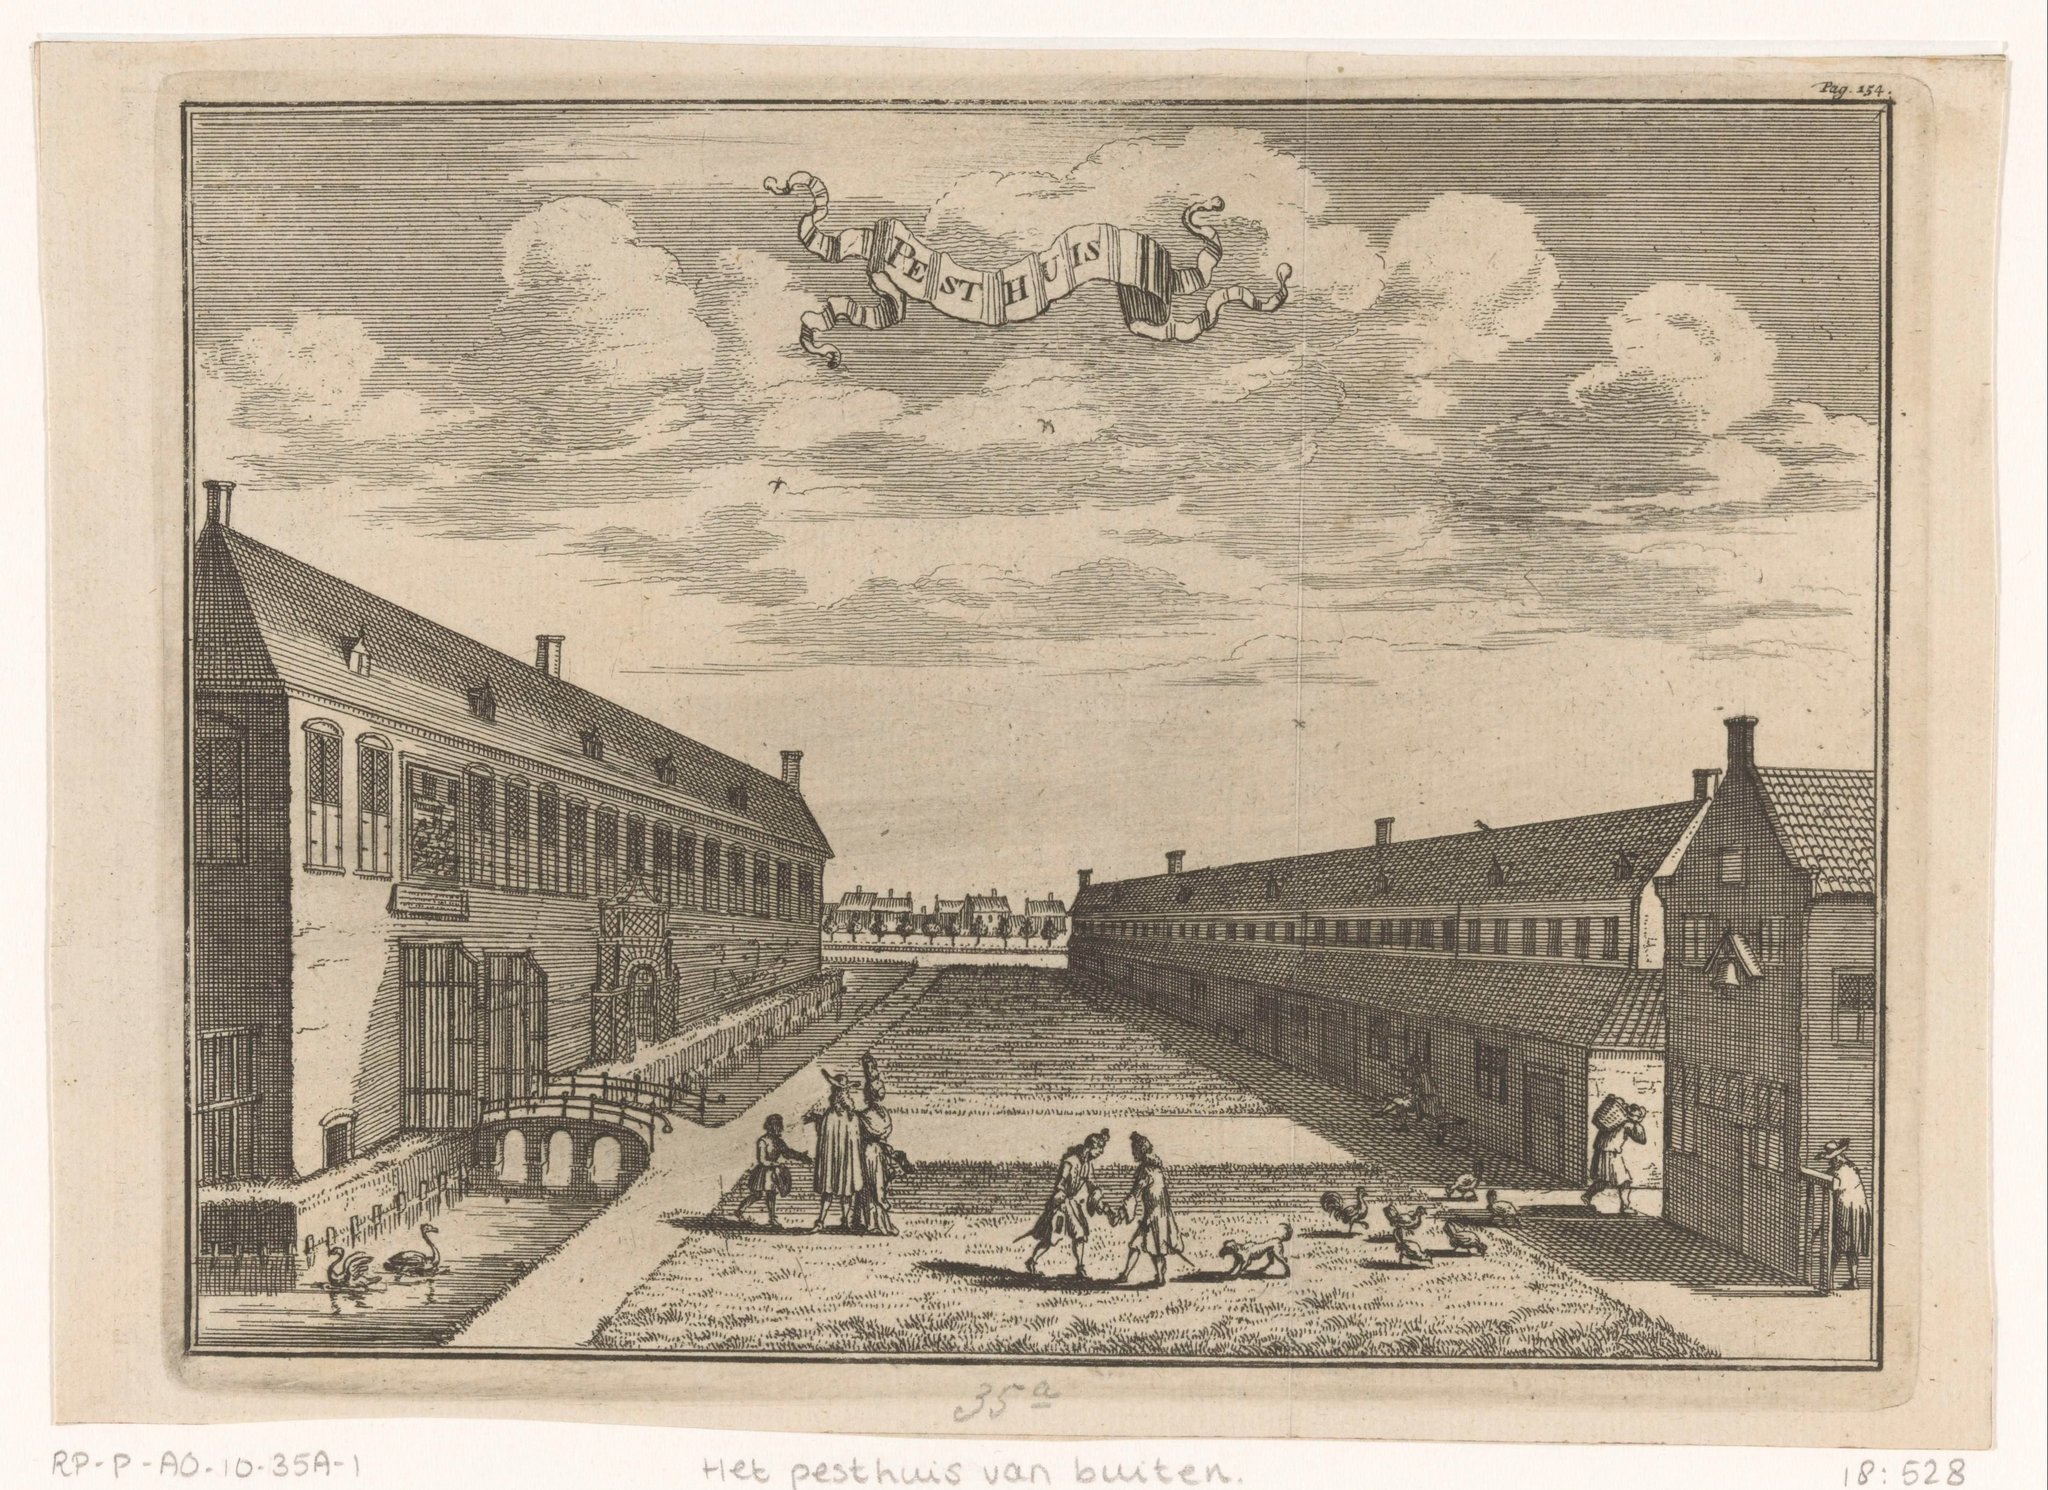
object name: print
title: Pest huis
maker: Anonymous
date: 1675-1699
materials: paper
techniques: etching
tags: hospital, leiden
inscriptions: collector's mark: Lugt 2228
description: Gezicht op een deel van de buitenkant van het Pesthuis te Leiden. Rechtsboven genummerd: pag. 154.